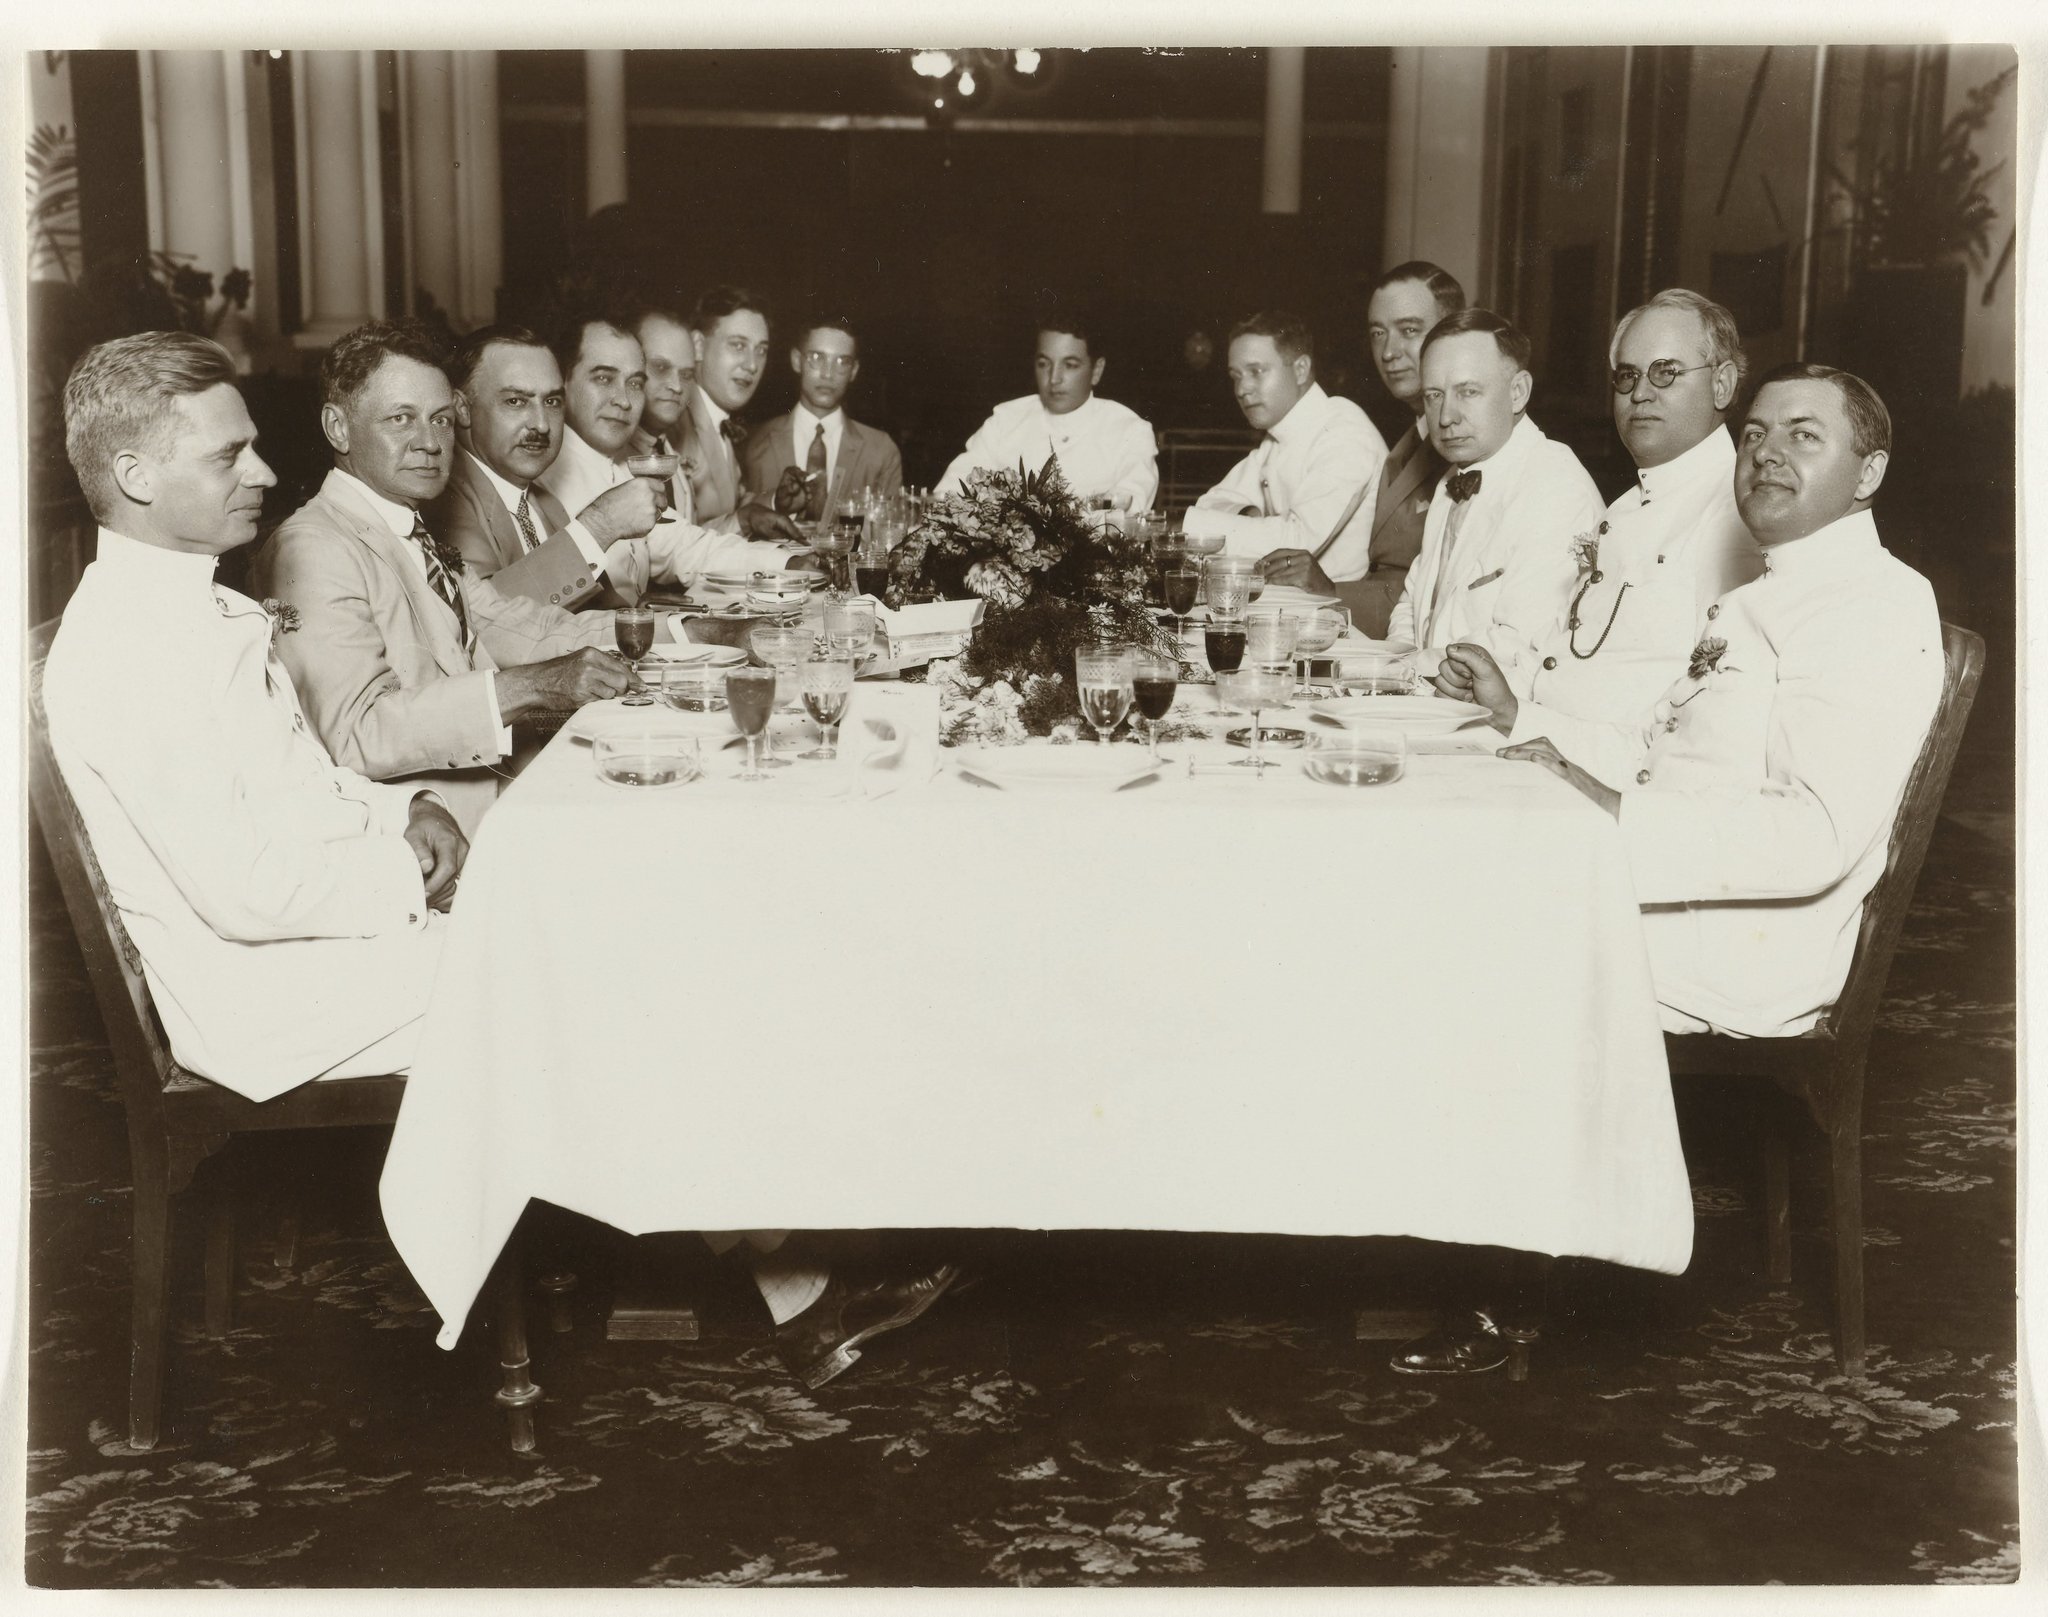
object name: photograph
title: Afscheidsfuif Boers in het gouverneurshuis Solo 29-7-1929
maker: Anonymous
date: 1929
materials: photographic support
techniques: photography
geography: solo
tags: letterie, solo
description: 13 Heren zijn aan het dineren tijdens het afscheidsfuif Boers in het gouverneurshuis Solo 29-7-1929.